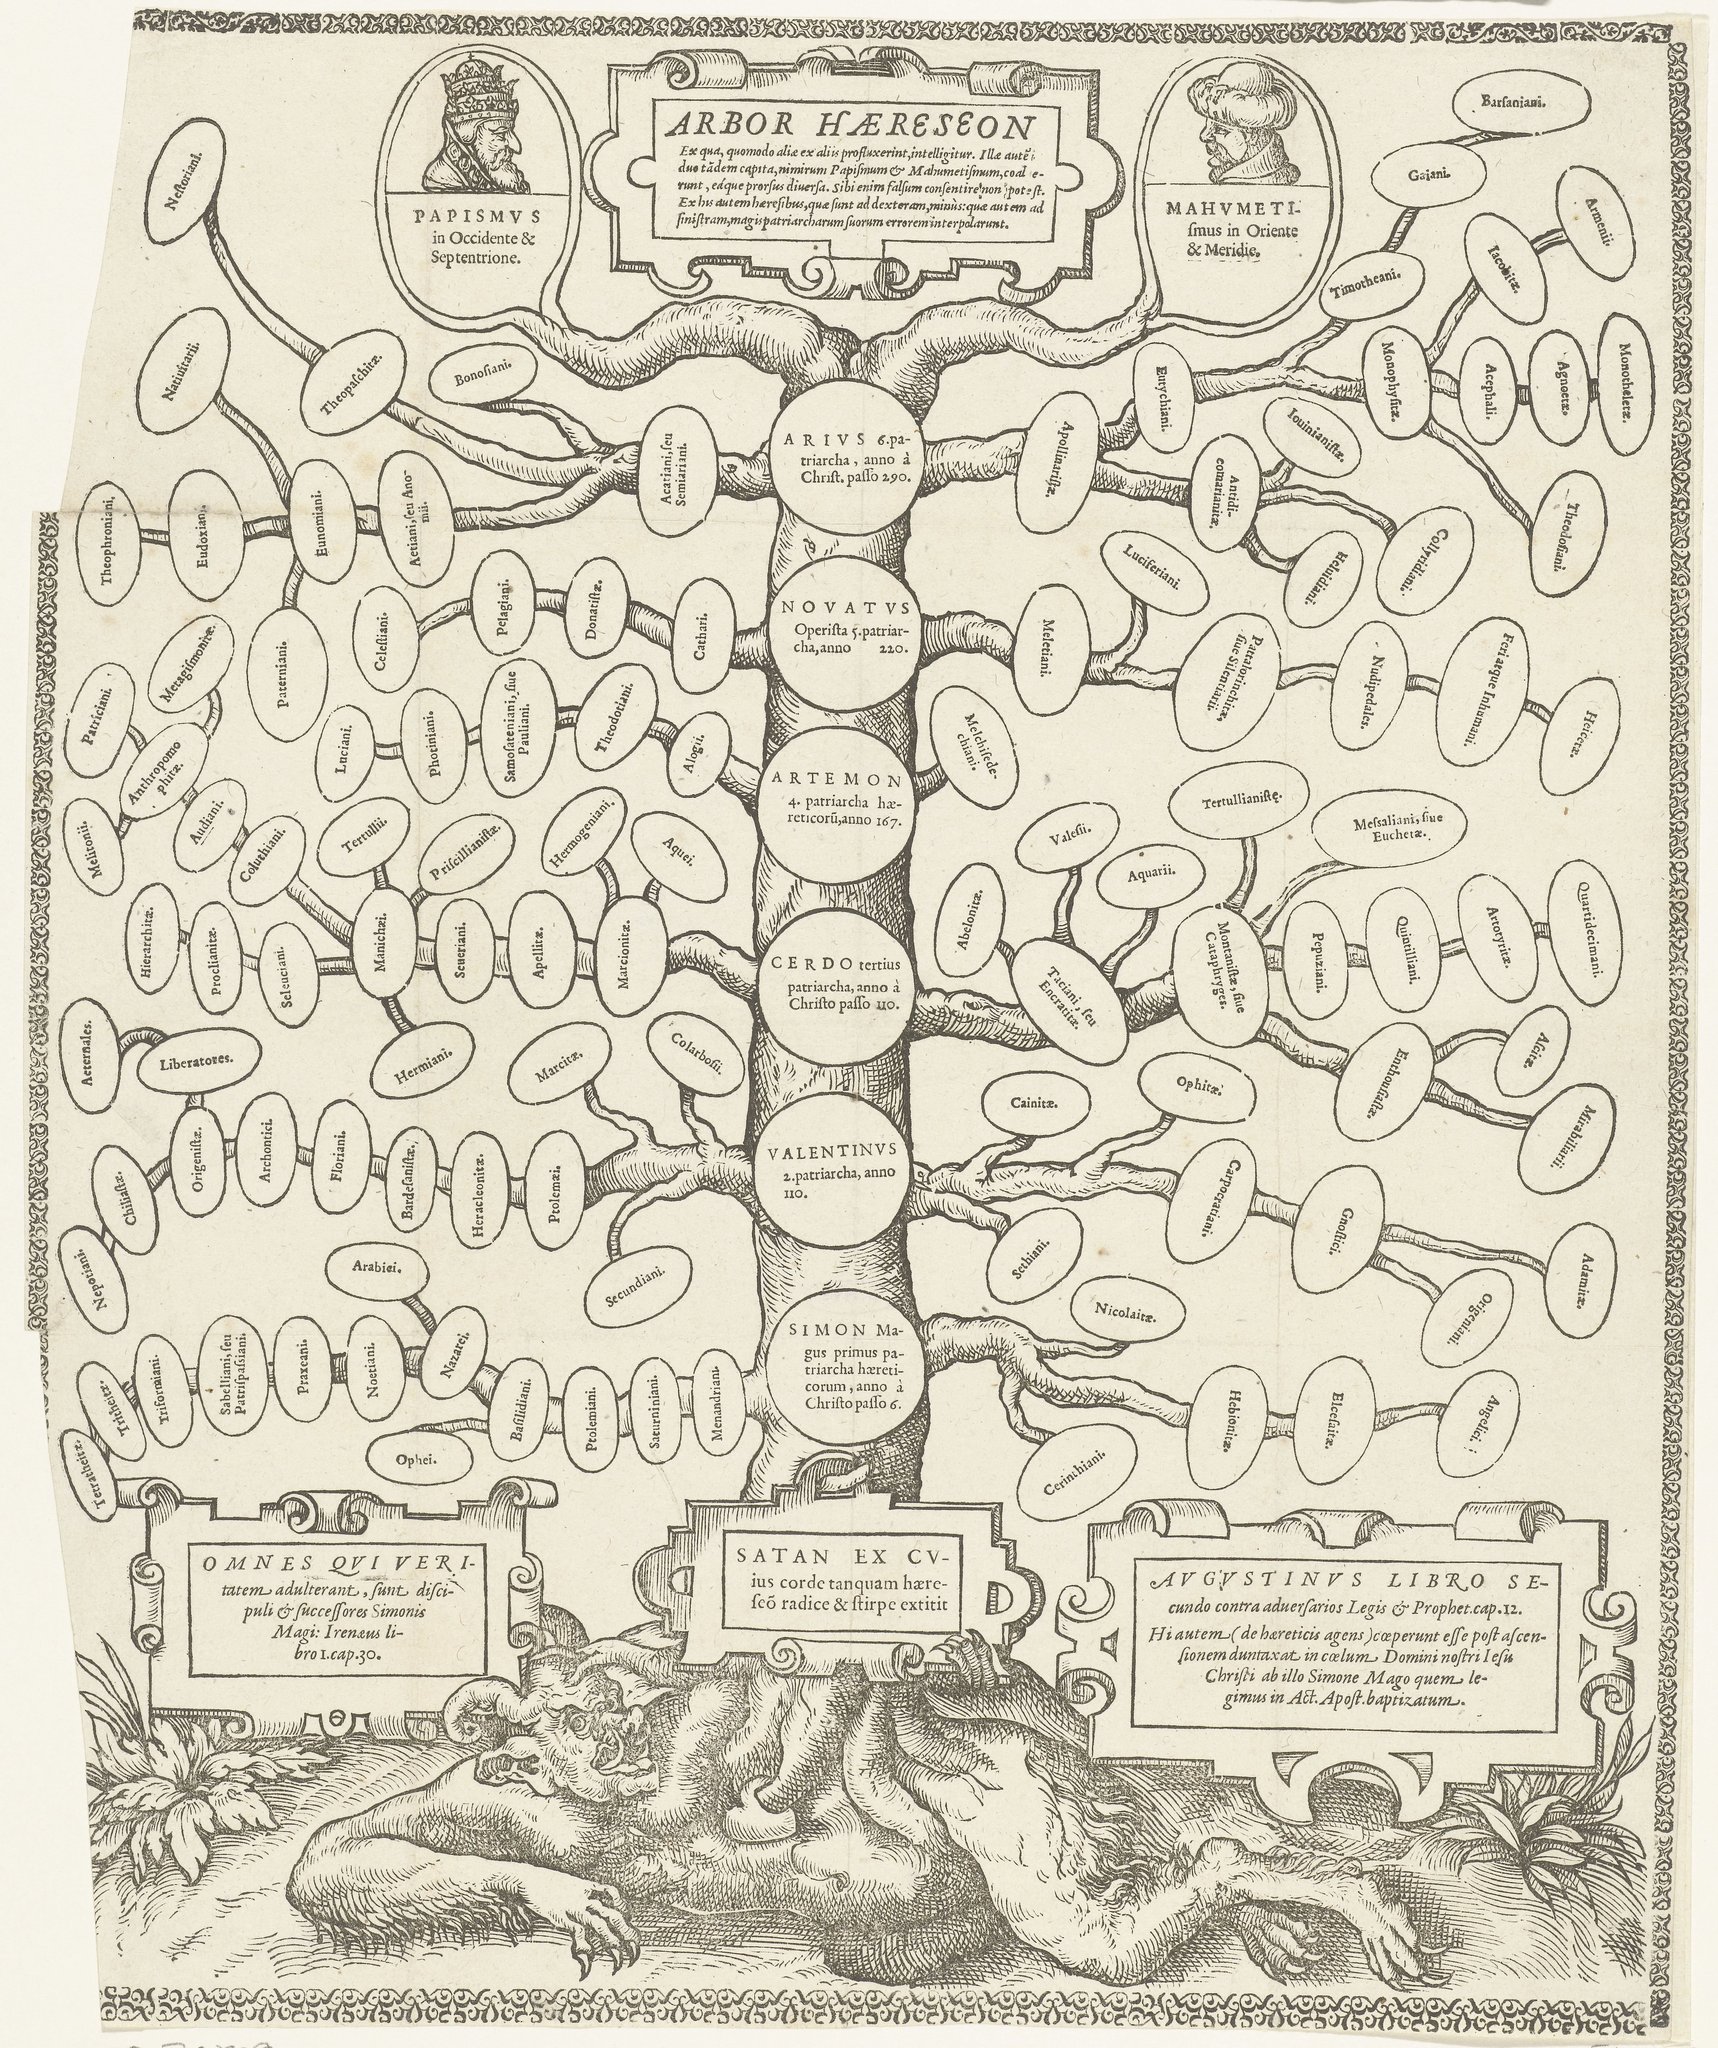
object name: print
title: Boom der ketterij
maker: Anonymous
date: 1550-1599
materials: paper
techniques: letterpress printing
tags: reformation (roman catholic church vs. protestantism), seer, prophet ~ islam, mohammedanism: mohammed, tree as a scheme of relations, diagram in form of a tree, pope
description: Boom der ketterij. Een boom ontspringt aan het lichaam van de op de grond liggende duivel. Aan de takken van de boom de namen van de vele ketterse sekten die voor de Hervorming ontstonden binnen de katholieke kerk. Bovenin links de paus en rechts Mohammed. Met een ornamentele rand. Alle opschriften in het Latijn. Spotprent op de Roomse kerk, ca. 1560.